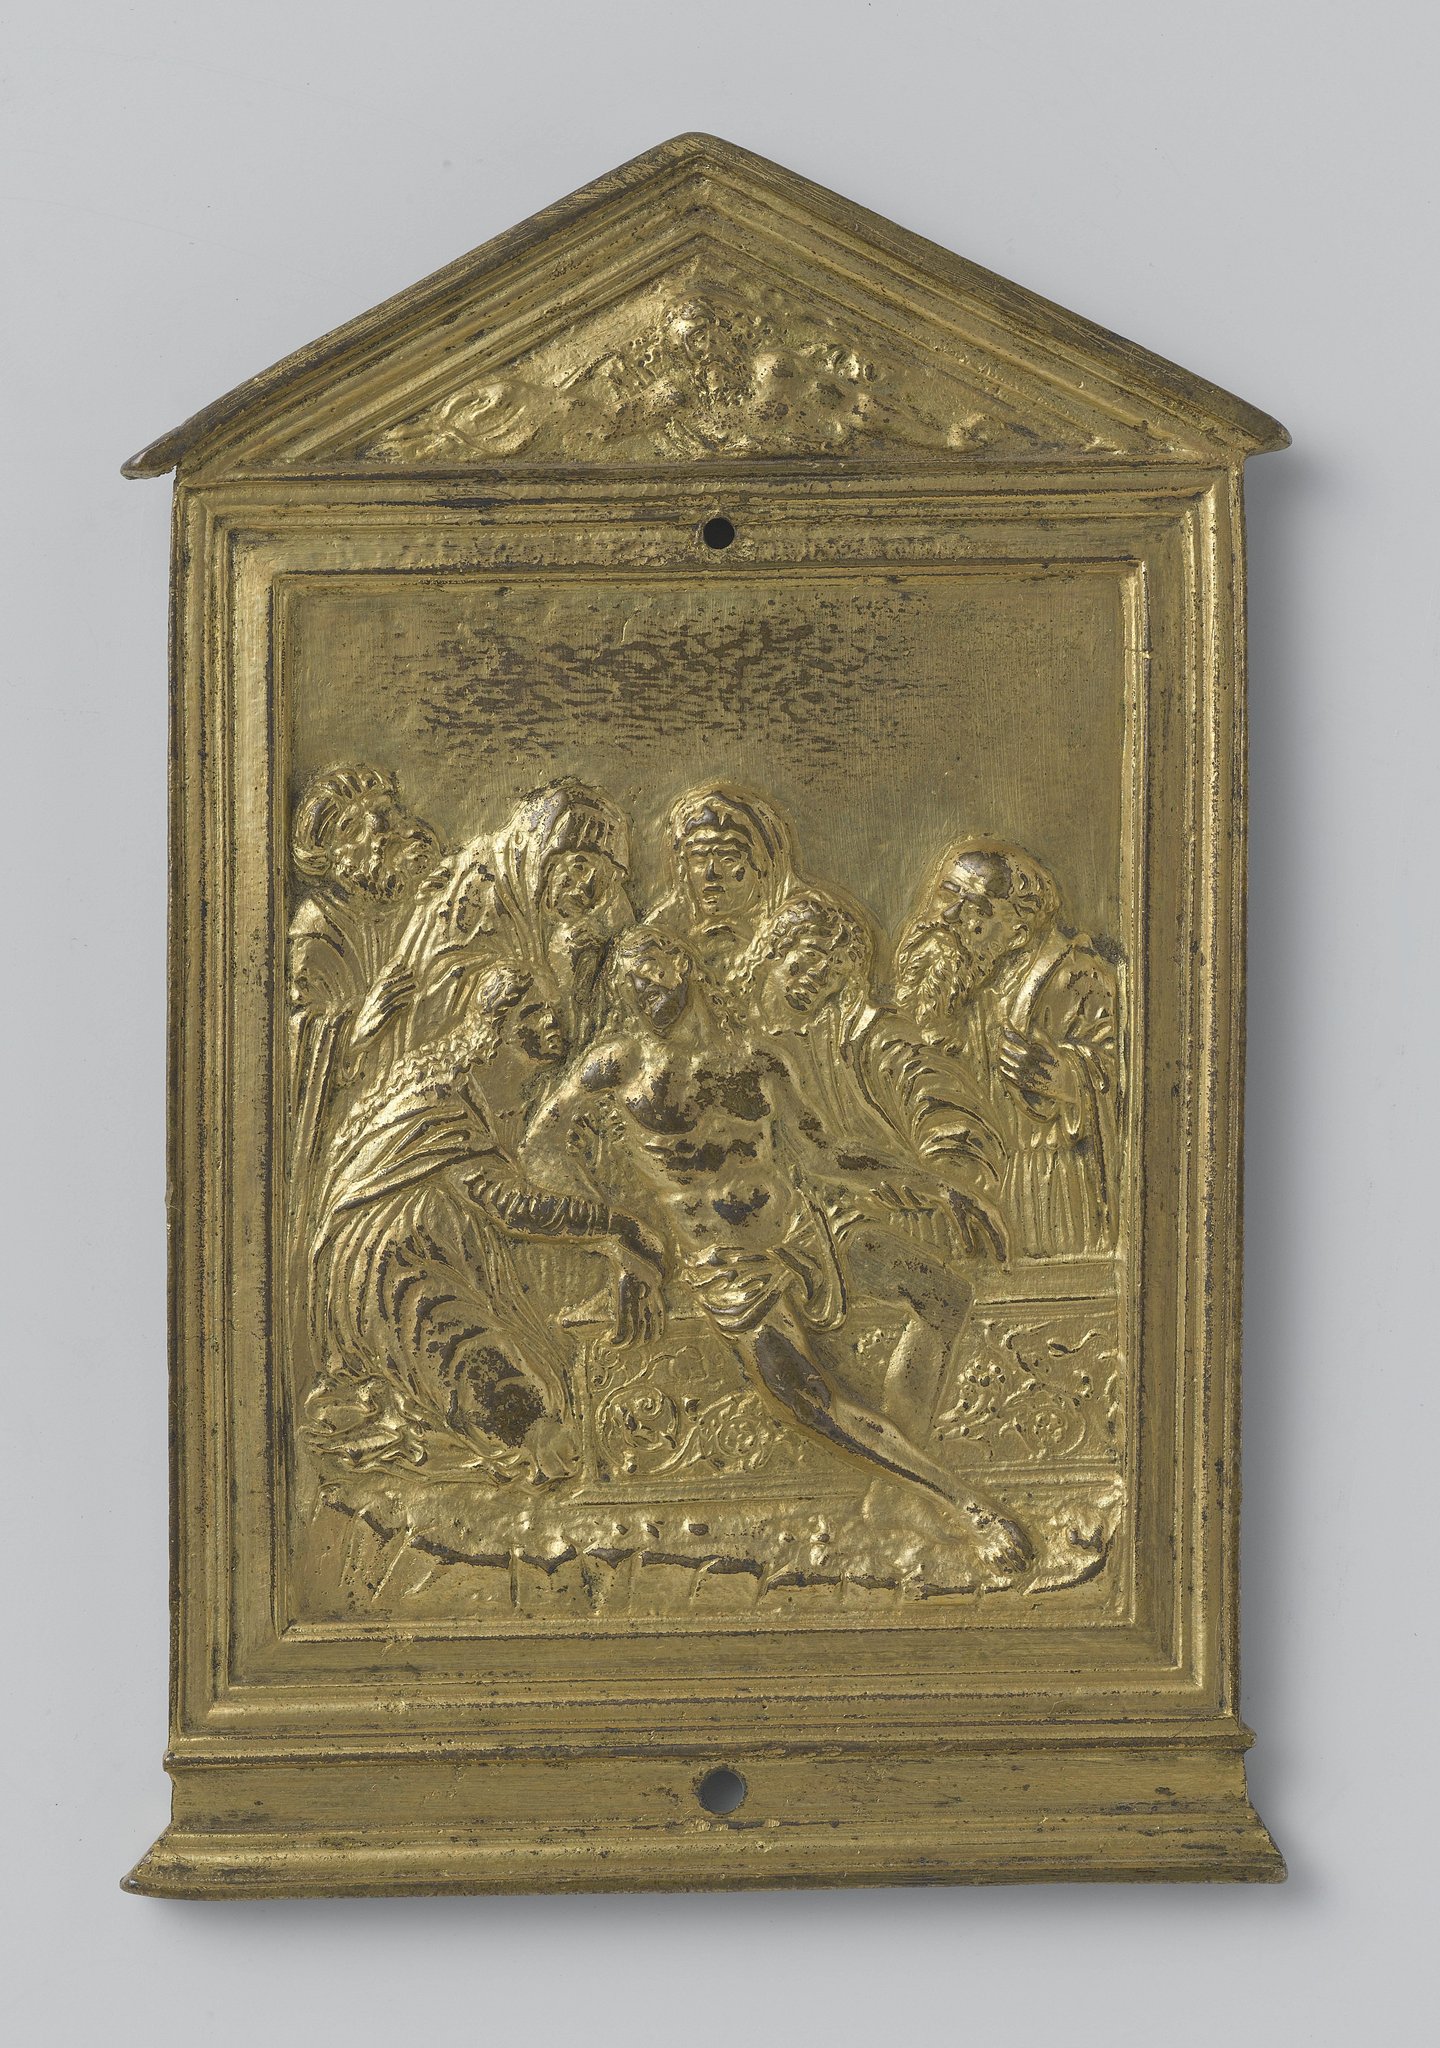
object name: sculpture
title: Graflegging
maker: moderno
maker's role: jeweler, sculptor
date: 1500-1525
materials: bronze